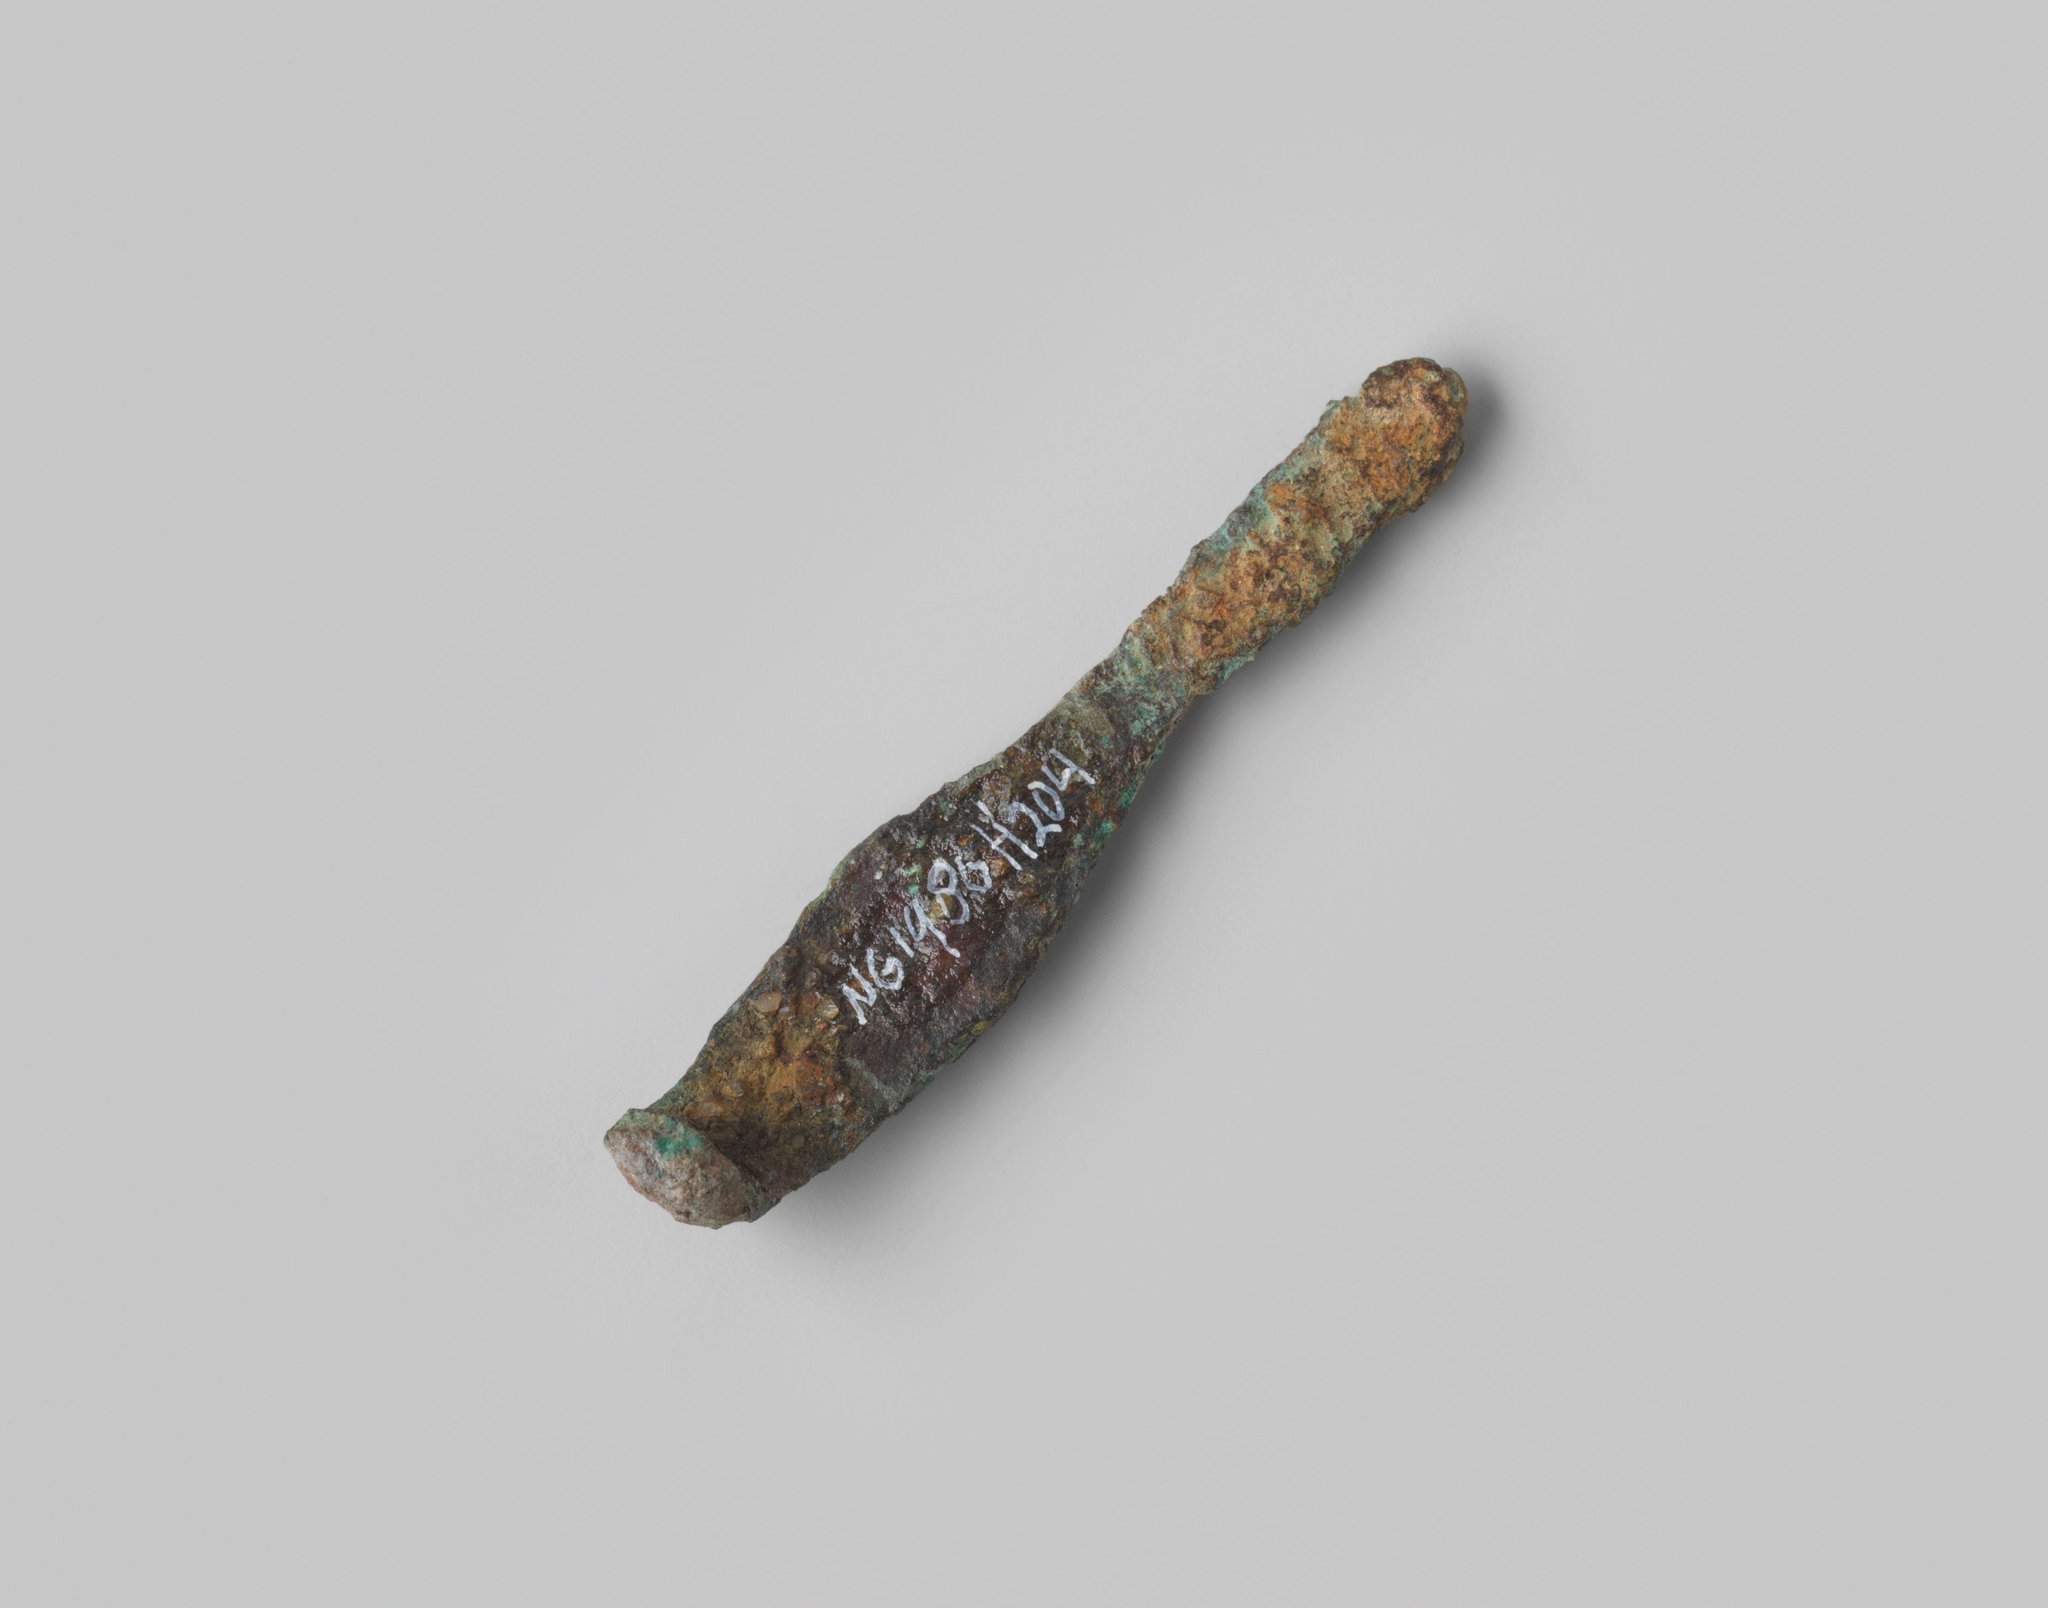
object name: clip bevestigingsmiddel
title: Clip van schede uit het wrak van de Oost-Indiëvaarder Hollandia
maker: Anonymous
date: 1700-1743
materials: copper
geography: netherlands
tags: verenigde oostindische compagnie, hollandia (schip), annet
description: Fragm, eroded, top missing, id. NG 1980-27H568.